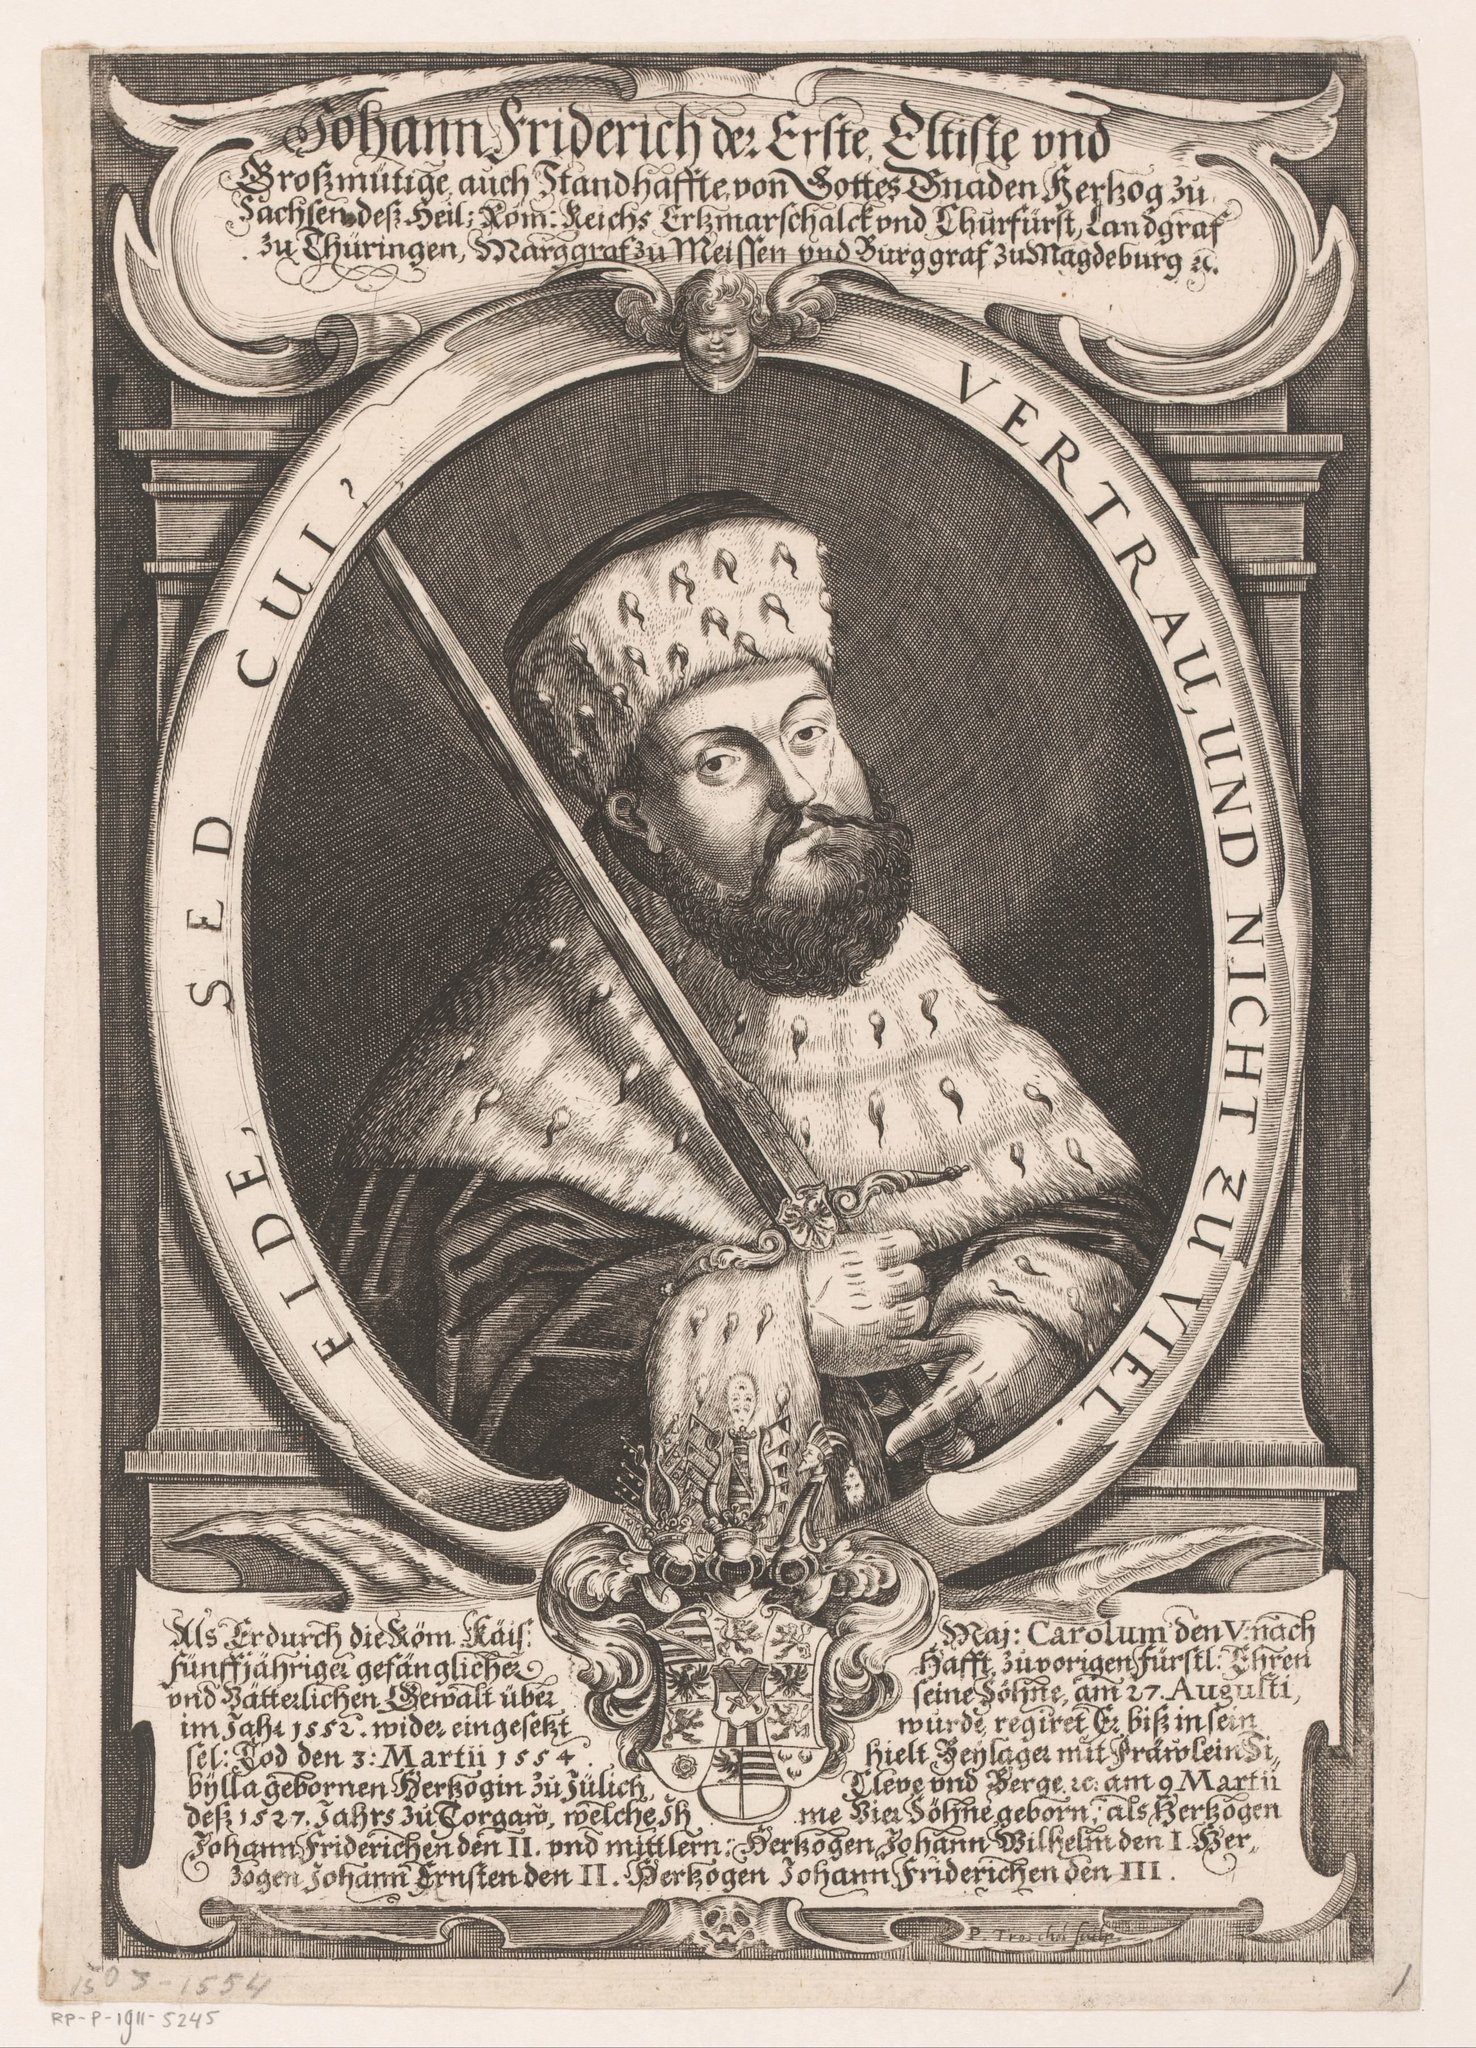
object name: print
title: Portret van Johan Frederik de Grootmoedige, keurvorst van Saksen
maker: peter troschel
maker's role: draughtsman, print maker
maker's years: 1620-1670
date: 1630-1670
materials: paper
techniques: engraving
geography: germany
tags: historical persons, armorial bearing, heraldry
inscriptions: collector's mark: Lugt 2228